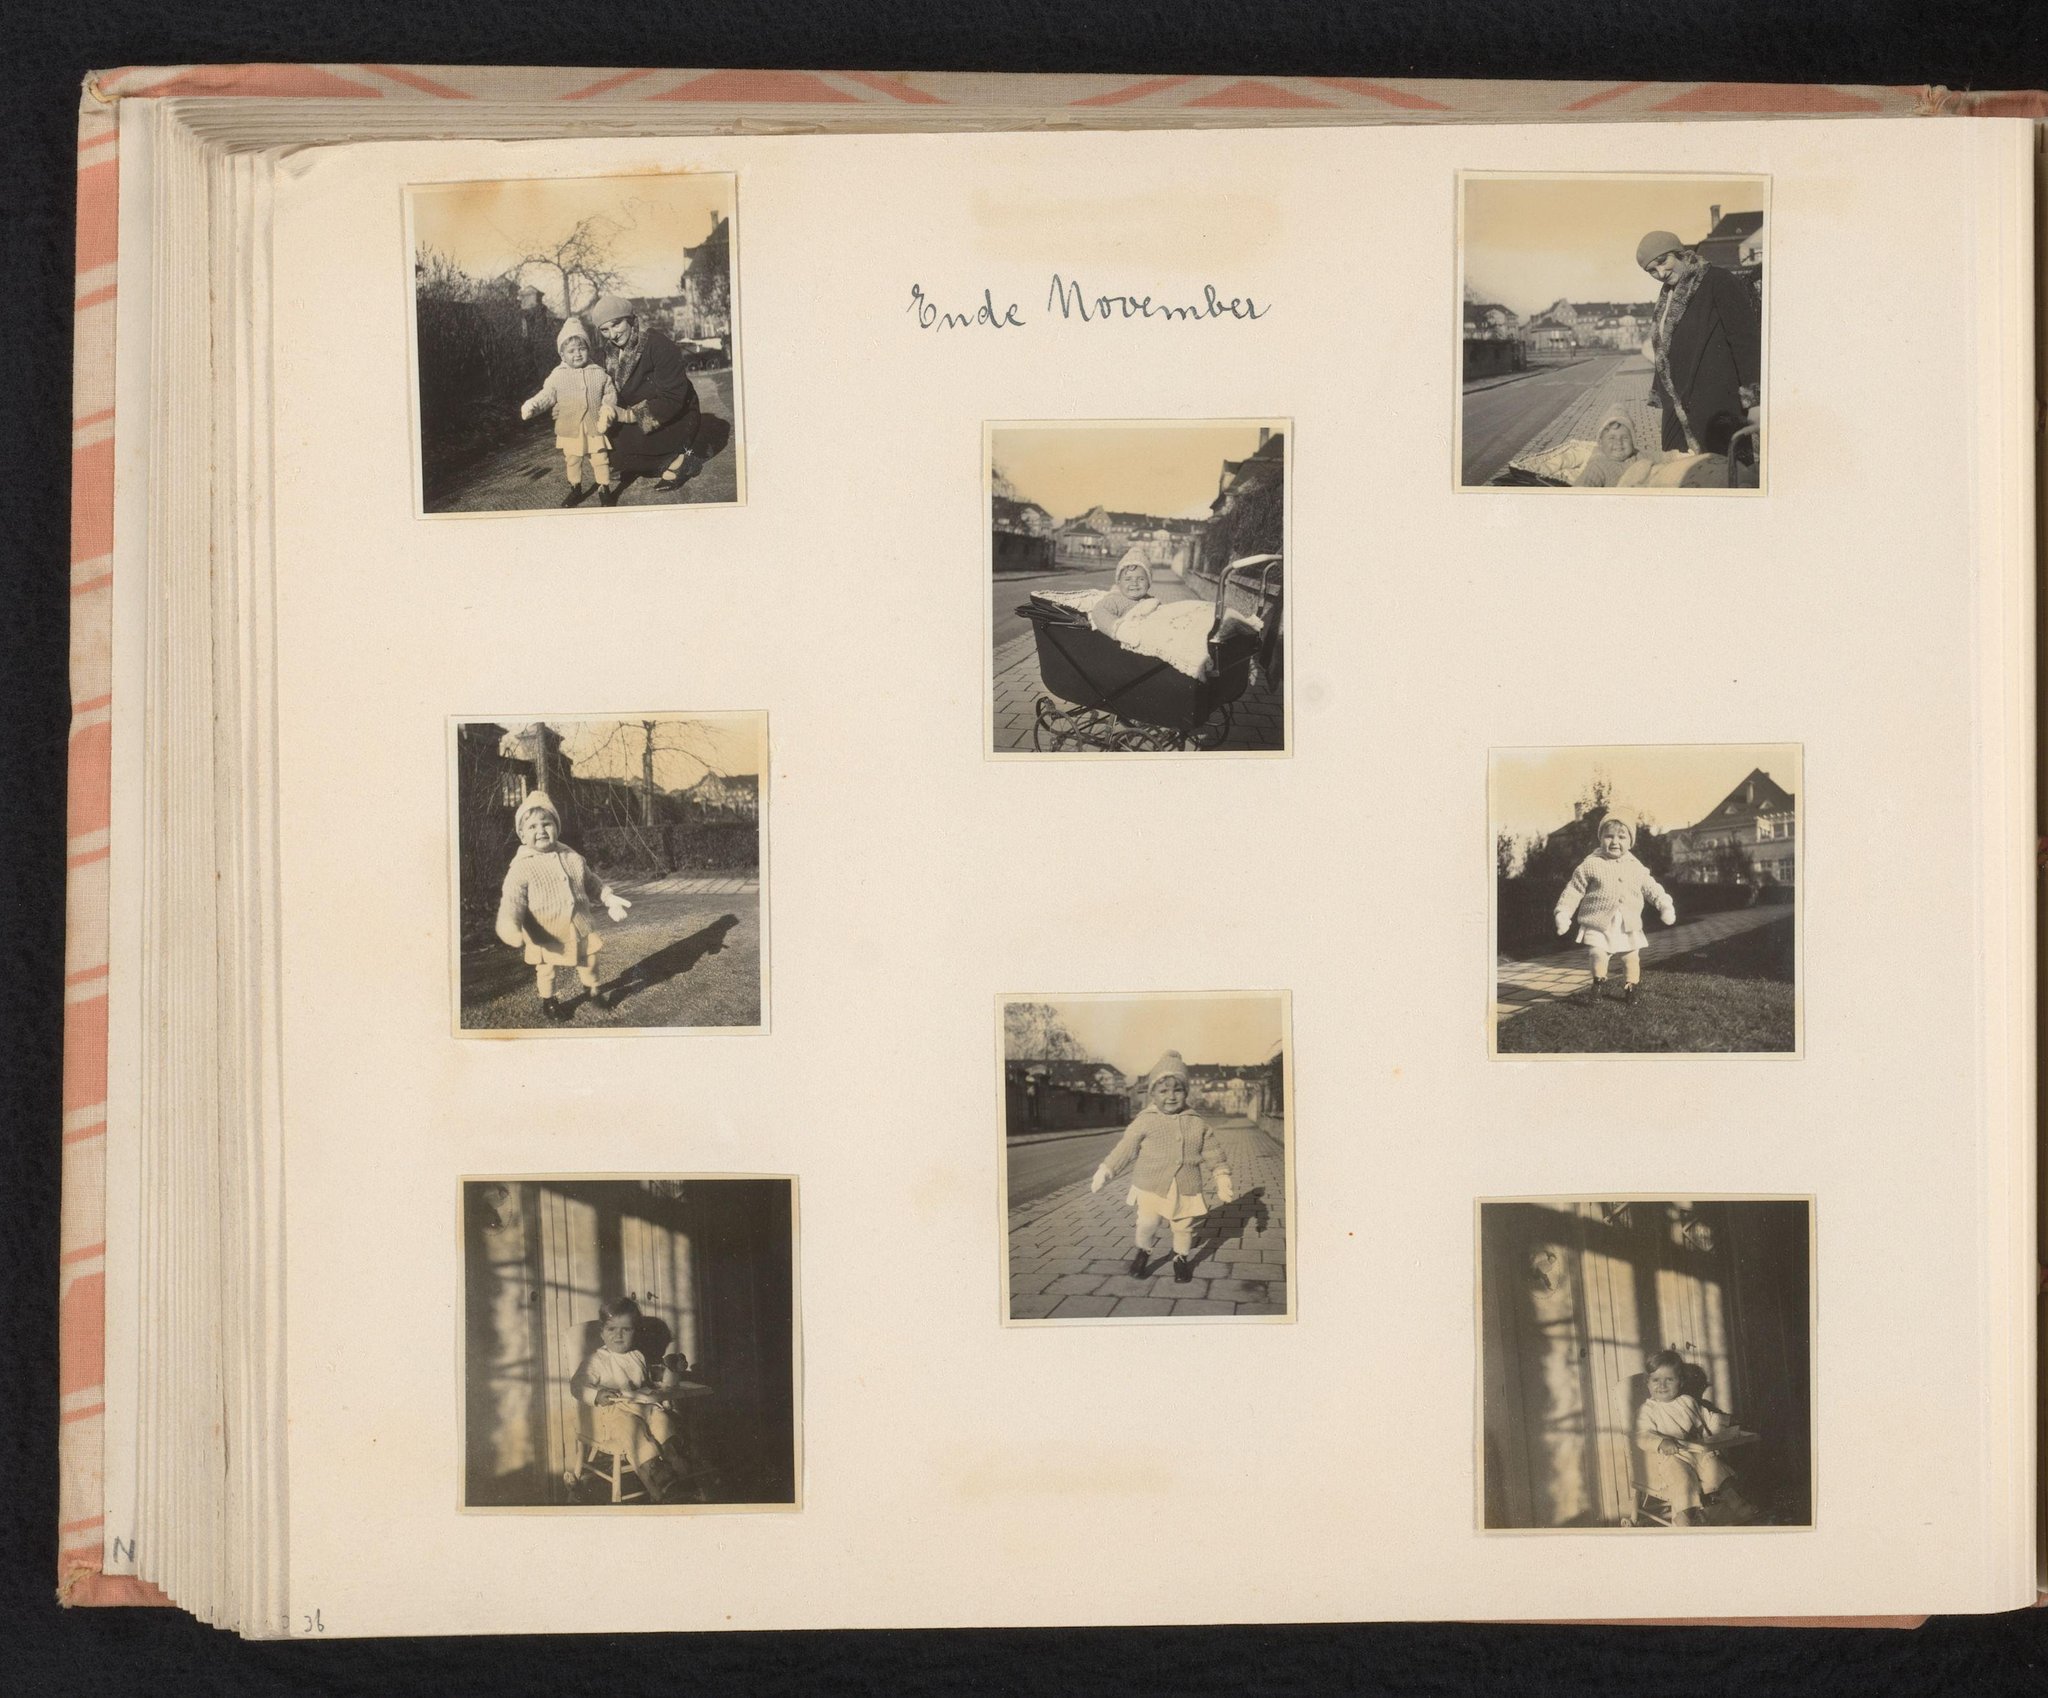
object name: photograph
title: Isabel Wachenheimer op straat, in een kinderwagen en in een kinderstoel met een onbekende vrouw, München, november 1929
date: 1911-1929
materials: paper, photographic support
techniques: gelatin silver print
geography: munich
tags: leiden, isabel wachenheimer-elon, family life at home, mother and baby or young child, infant, baby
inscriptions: inscription: ‘Ende November’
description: Albumblad met acht foto's. Foto's linksboven en rechtsboven, Isabel Wachenheimer (links) en onbekende vrouw (rechts); zes overige foto's, Isabel Wachenheimer. Onderdeel van het fotoalbum met foto's van Isabel Wachenheimer als kind (1928-1931).